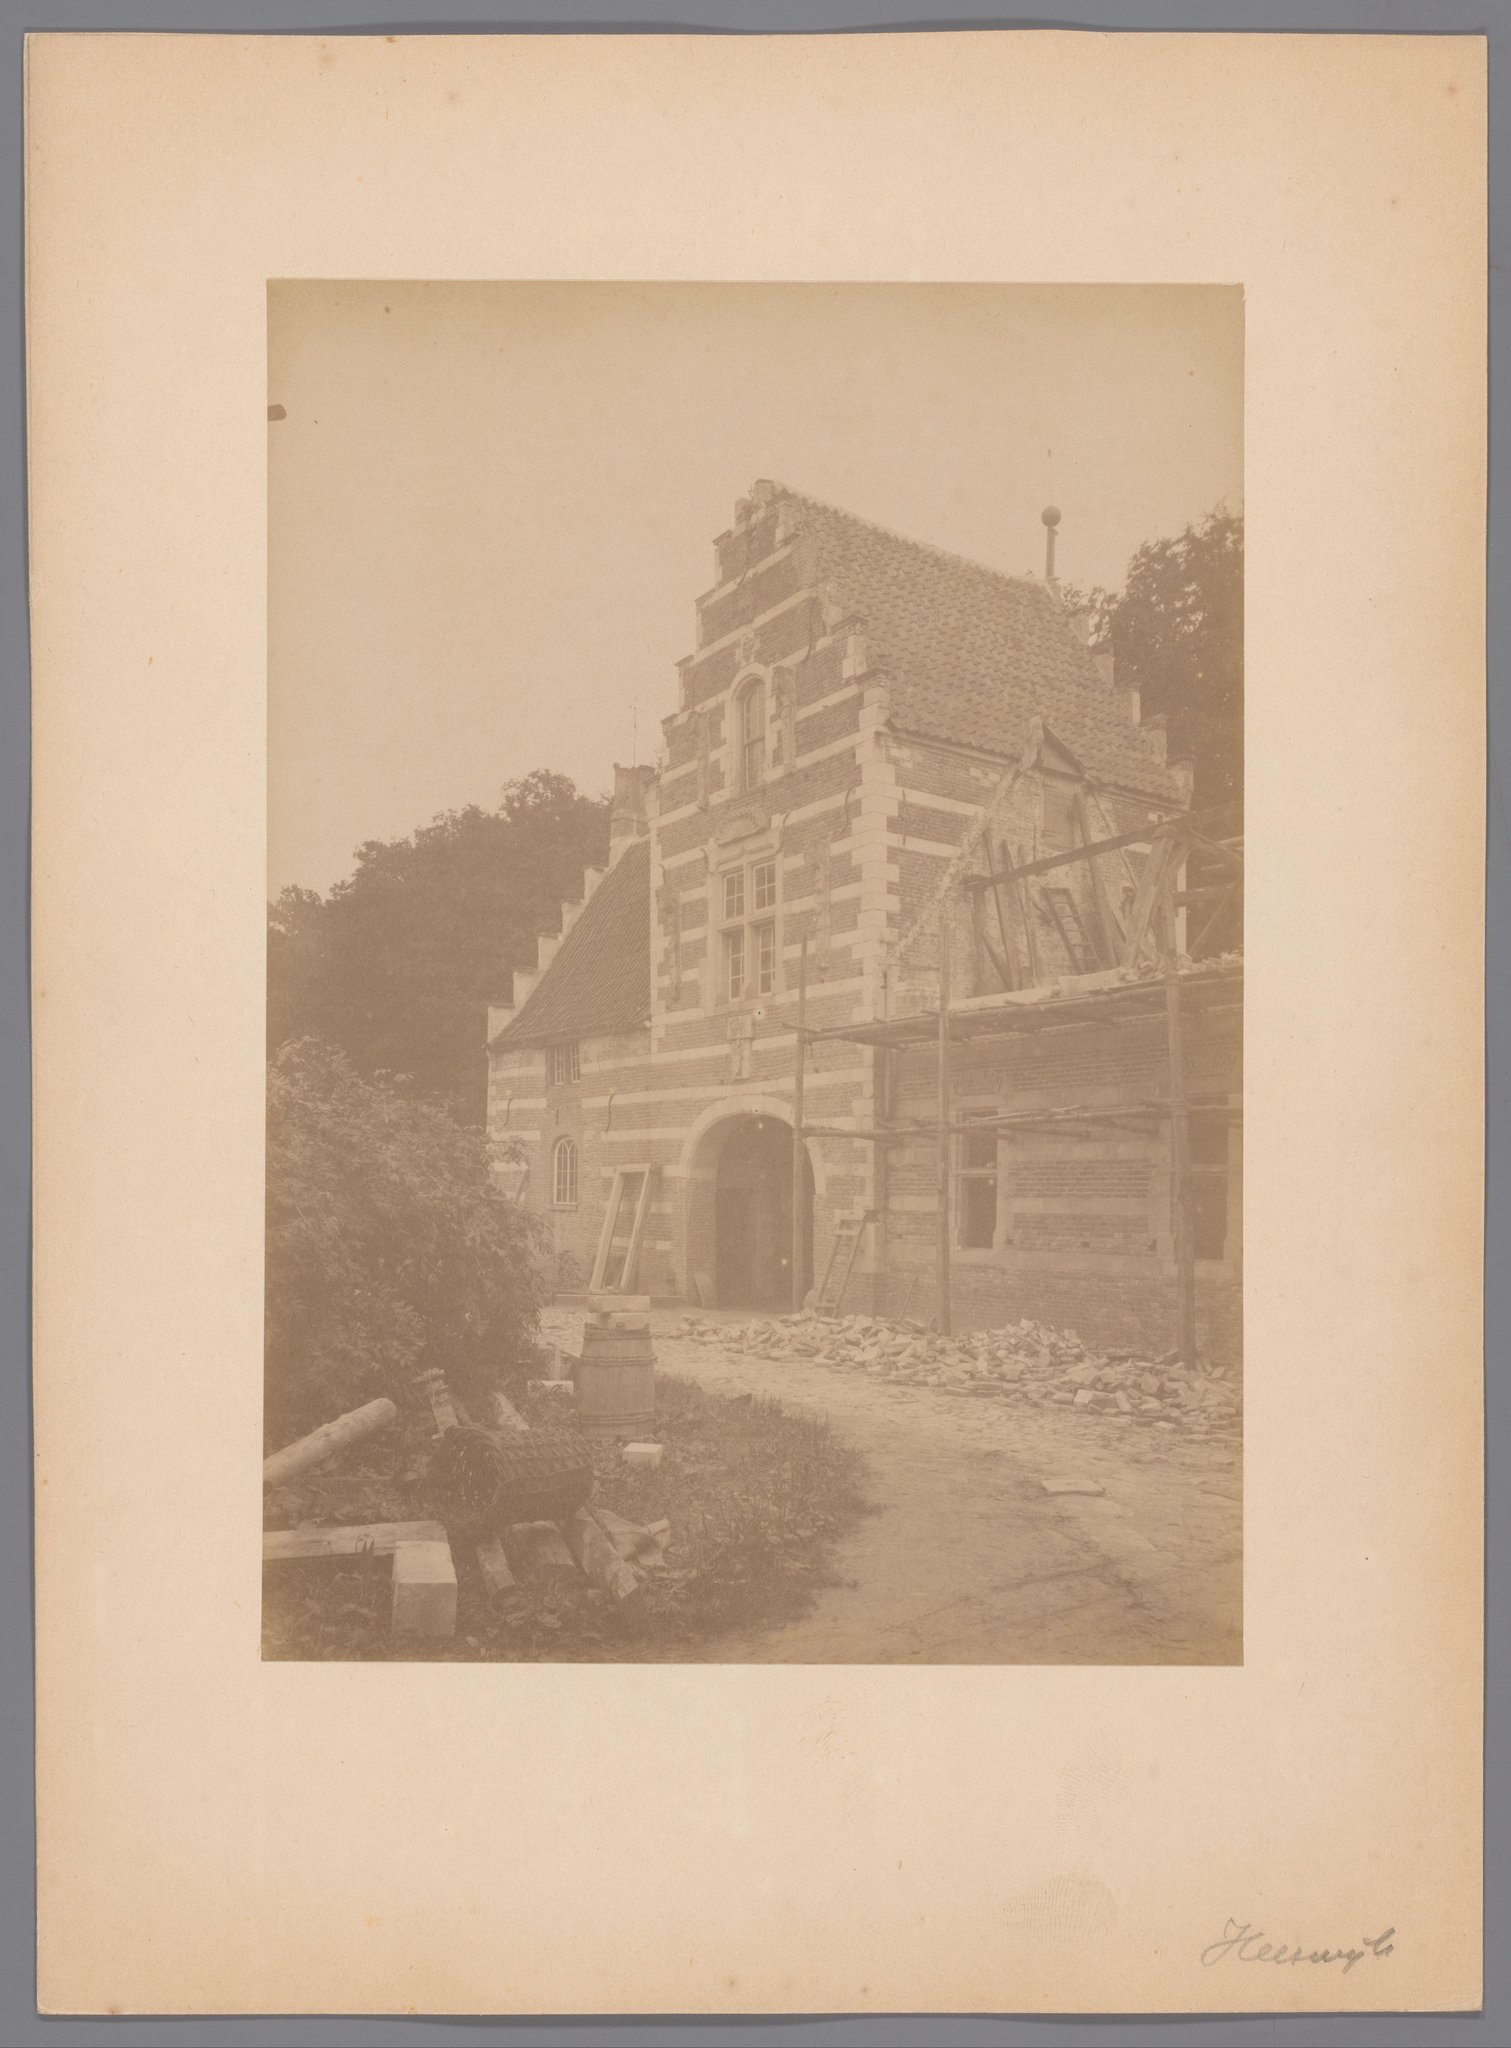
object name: photograph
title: Gedeelte van Kasteel Heeswijk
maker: anoniem (monumentenzorg)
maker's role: fotograaf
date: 1892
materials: cardboard, photographic support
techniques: albumen print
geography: kasteel heeswijk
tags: castle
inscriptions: annotation: ‘Heeswijk’, annotation: ‘Kasteel te Heeswijk (N.B.)/ voorbouw binnen[...]/ Aug 1892’